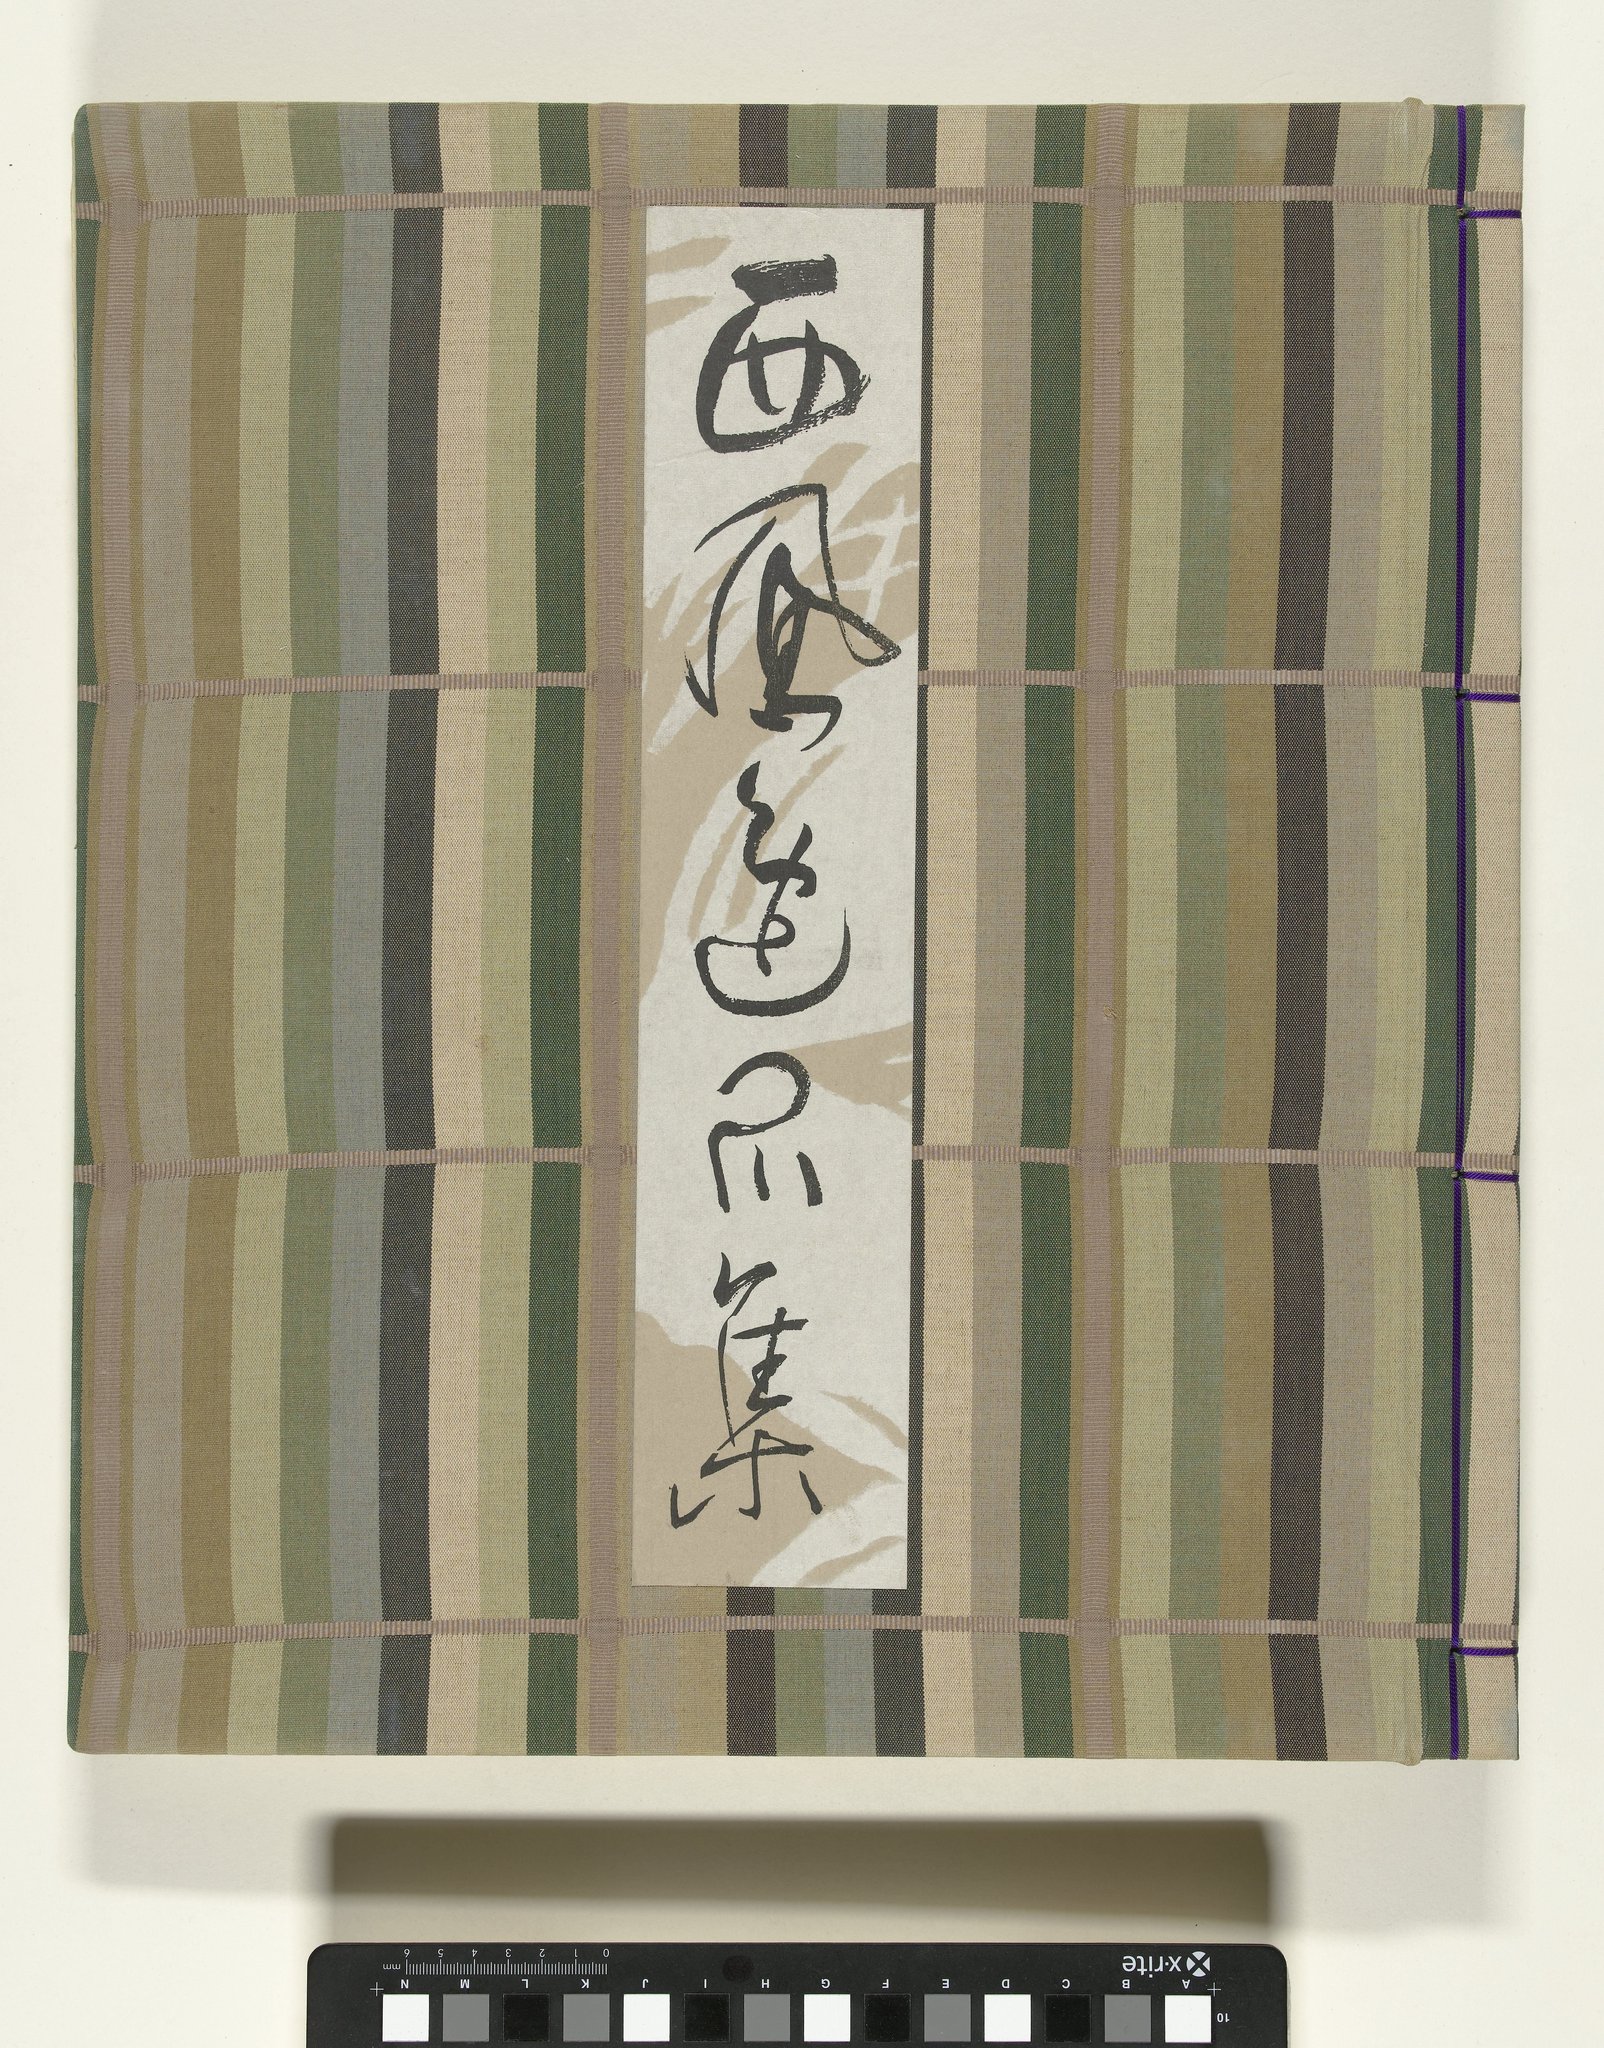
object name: prentrecueil, prentenalbum, prentalbum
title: Meesterwerken van Seiho - deel één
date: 1937-1942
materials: paper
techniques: woodcut, letterpress printing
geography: japan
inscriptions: date